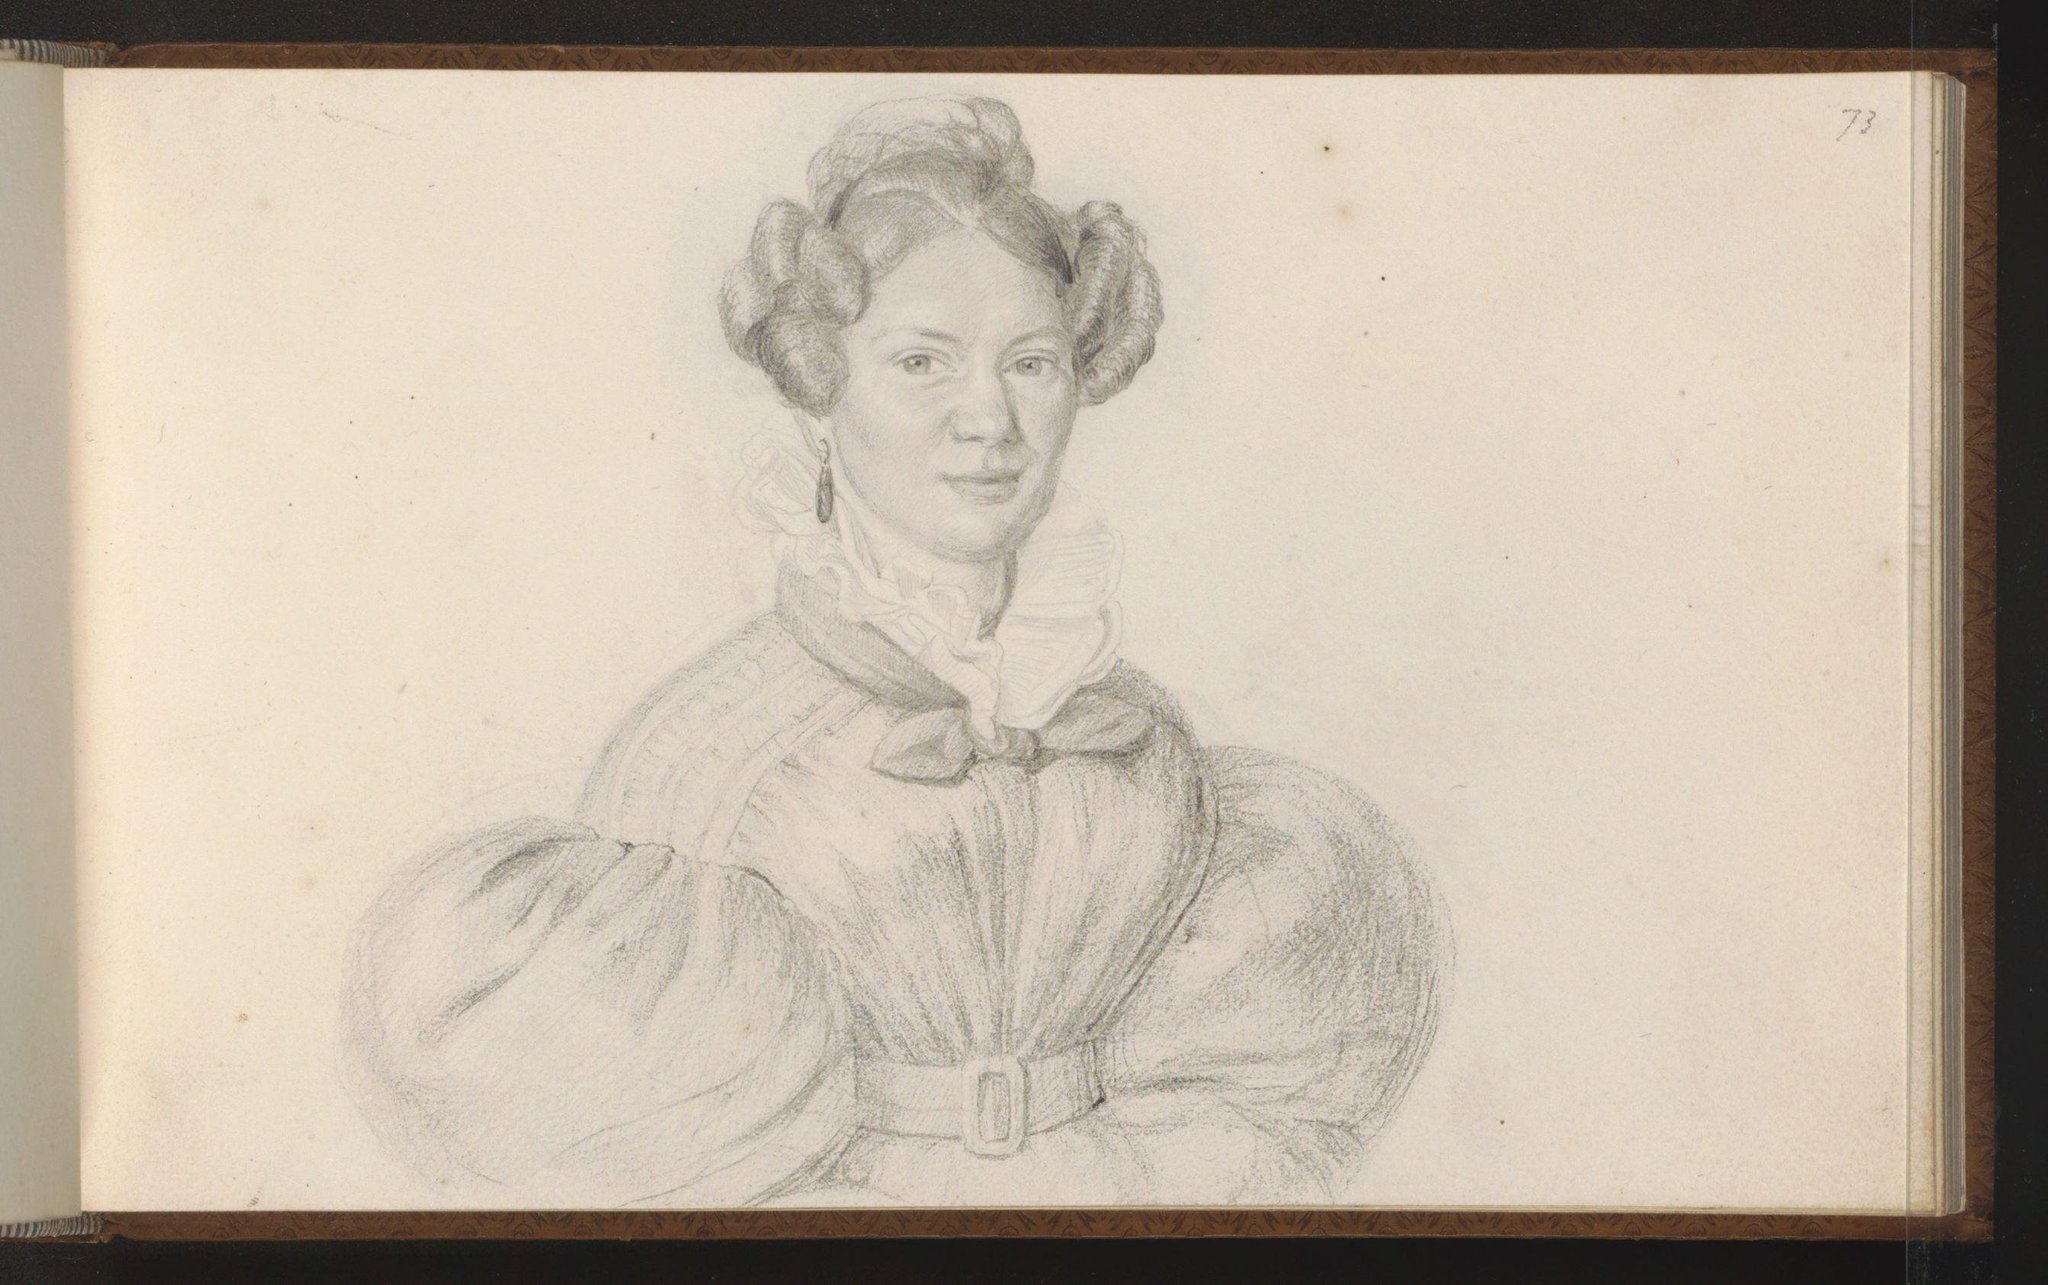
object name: sketchbook leaf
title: Portret van een vrouw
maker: christian heinrich gottlieb steuerwald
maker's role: draughtsman, print maker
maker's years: 1802-1874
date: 1834-1844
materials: paper, pencil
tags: historical persons (portraits and scenes from the life)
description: Mogelijk een portret van tante Backer. Bladzijde 73 uit een schetsboek met 188 bladzijden.